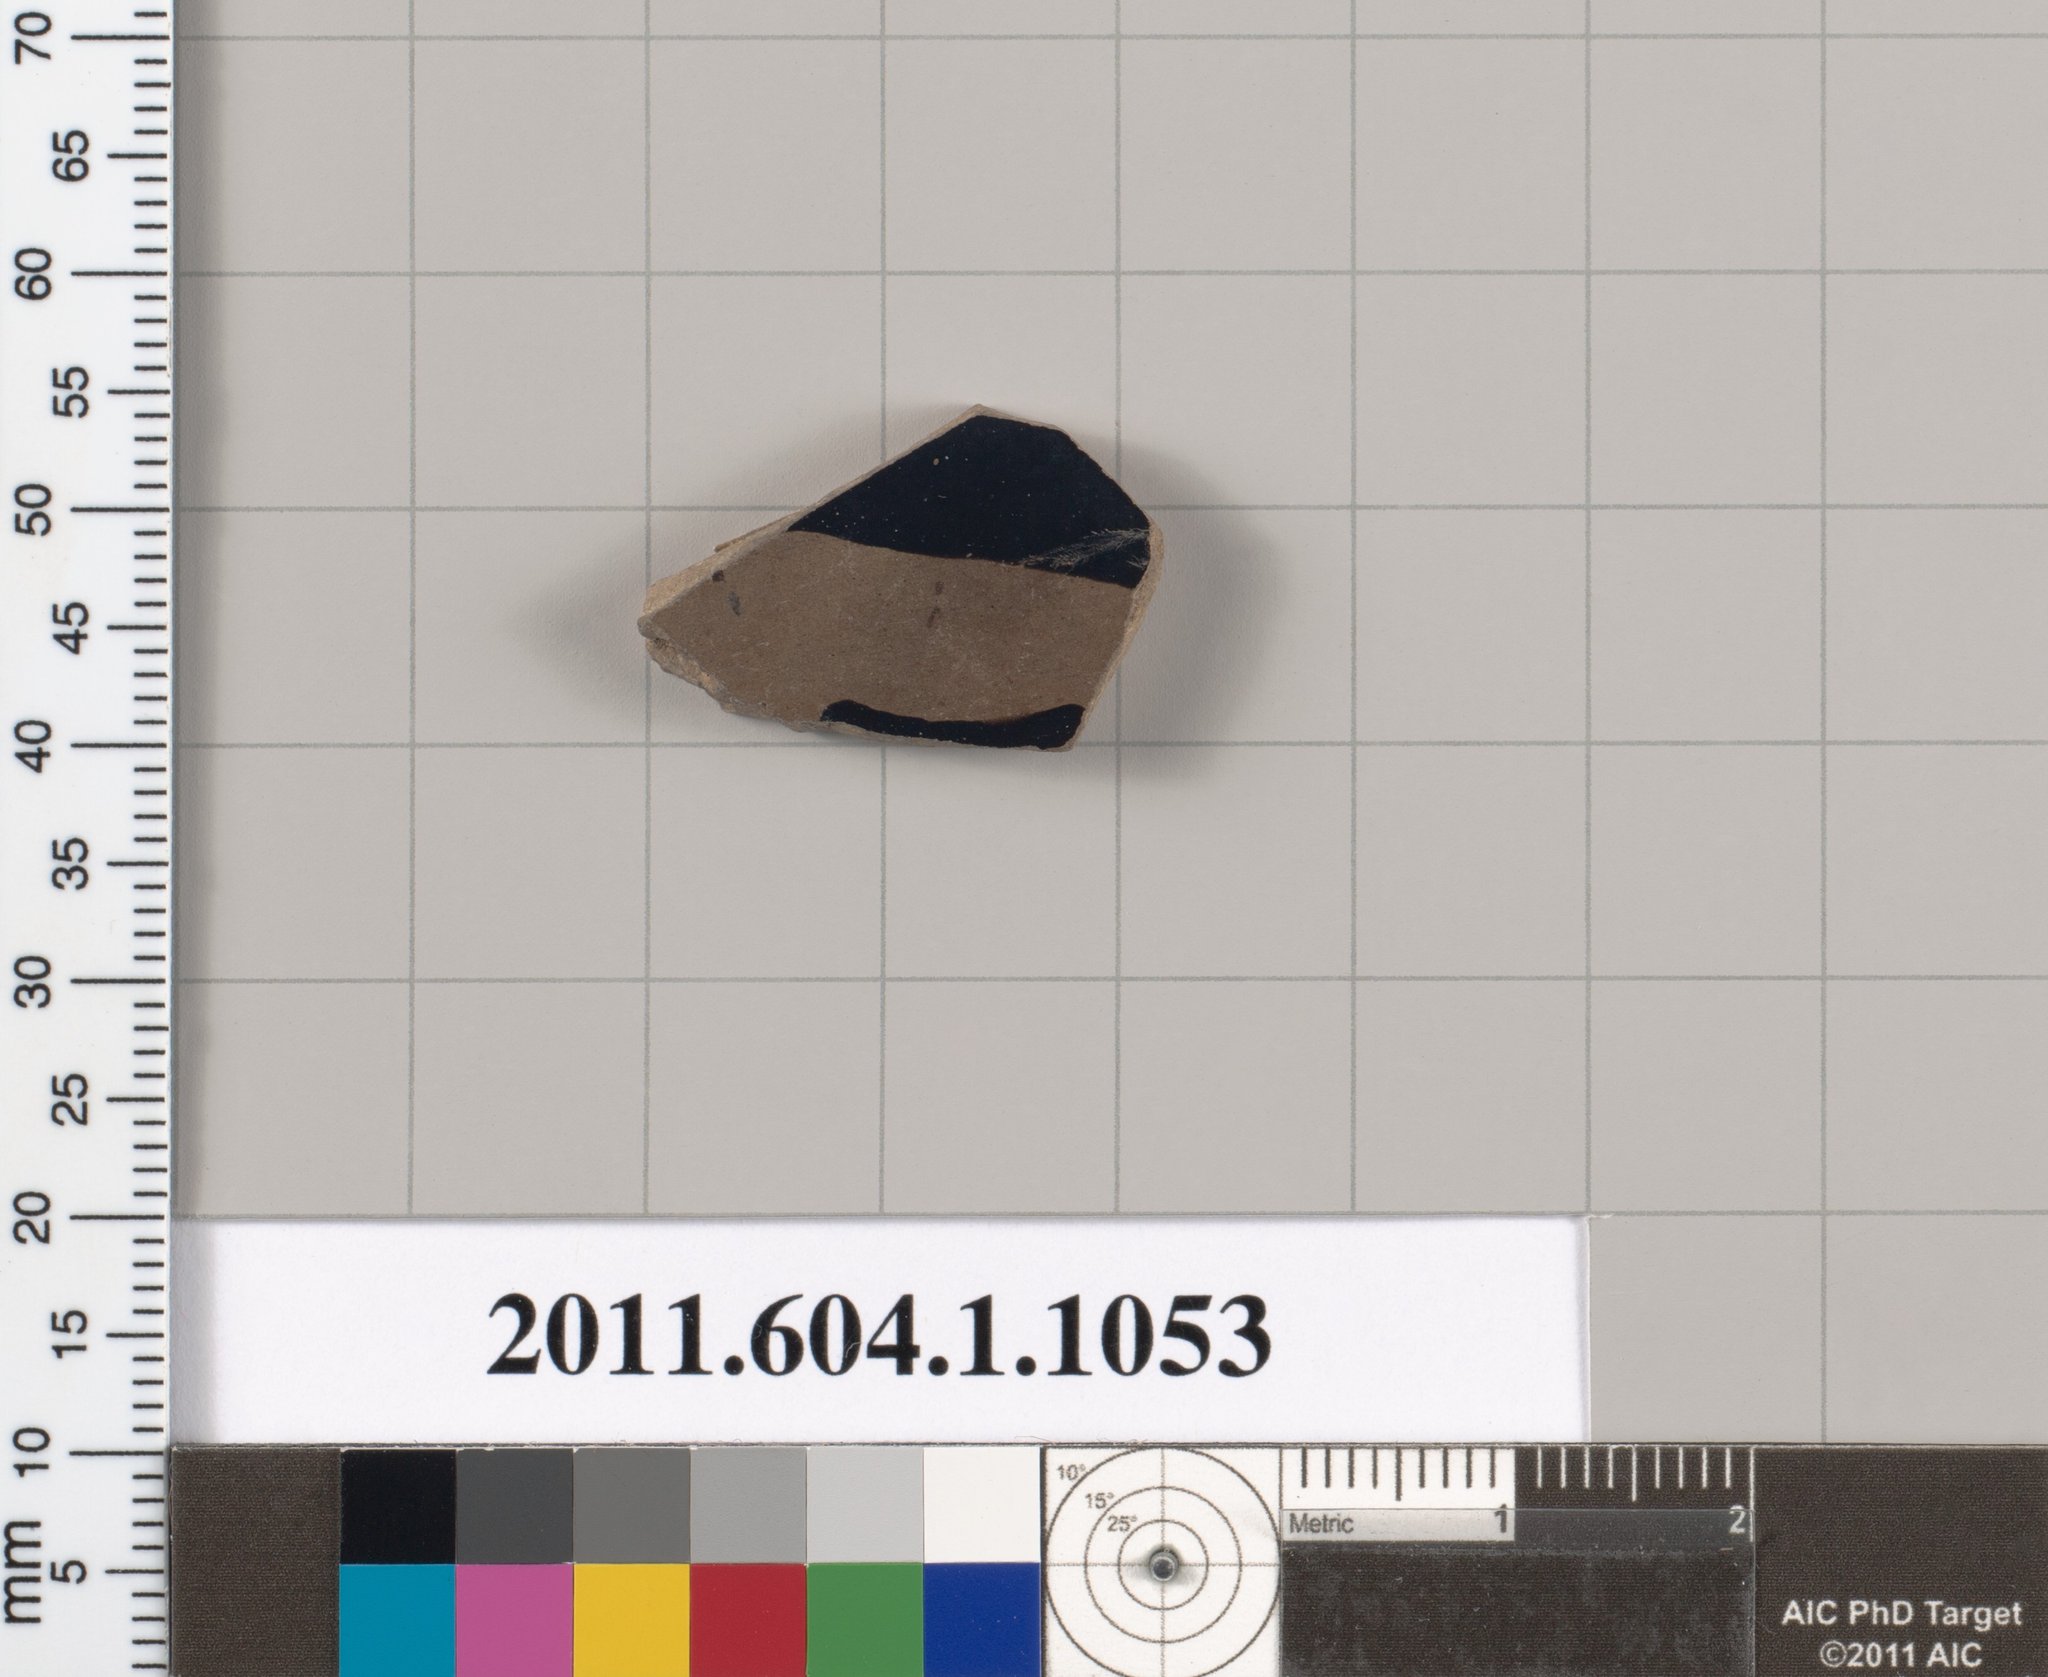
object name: kylix fragment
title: Terracotta fragment of a kylix (drinking cup)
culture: greek, attic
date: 475-451 BCE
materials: terracotta